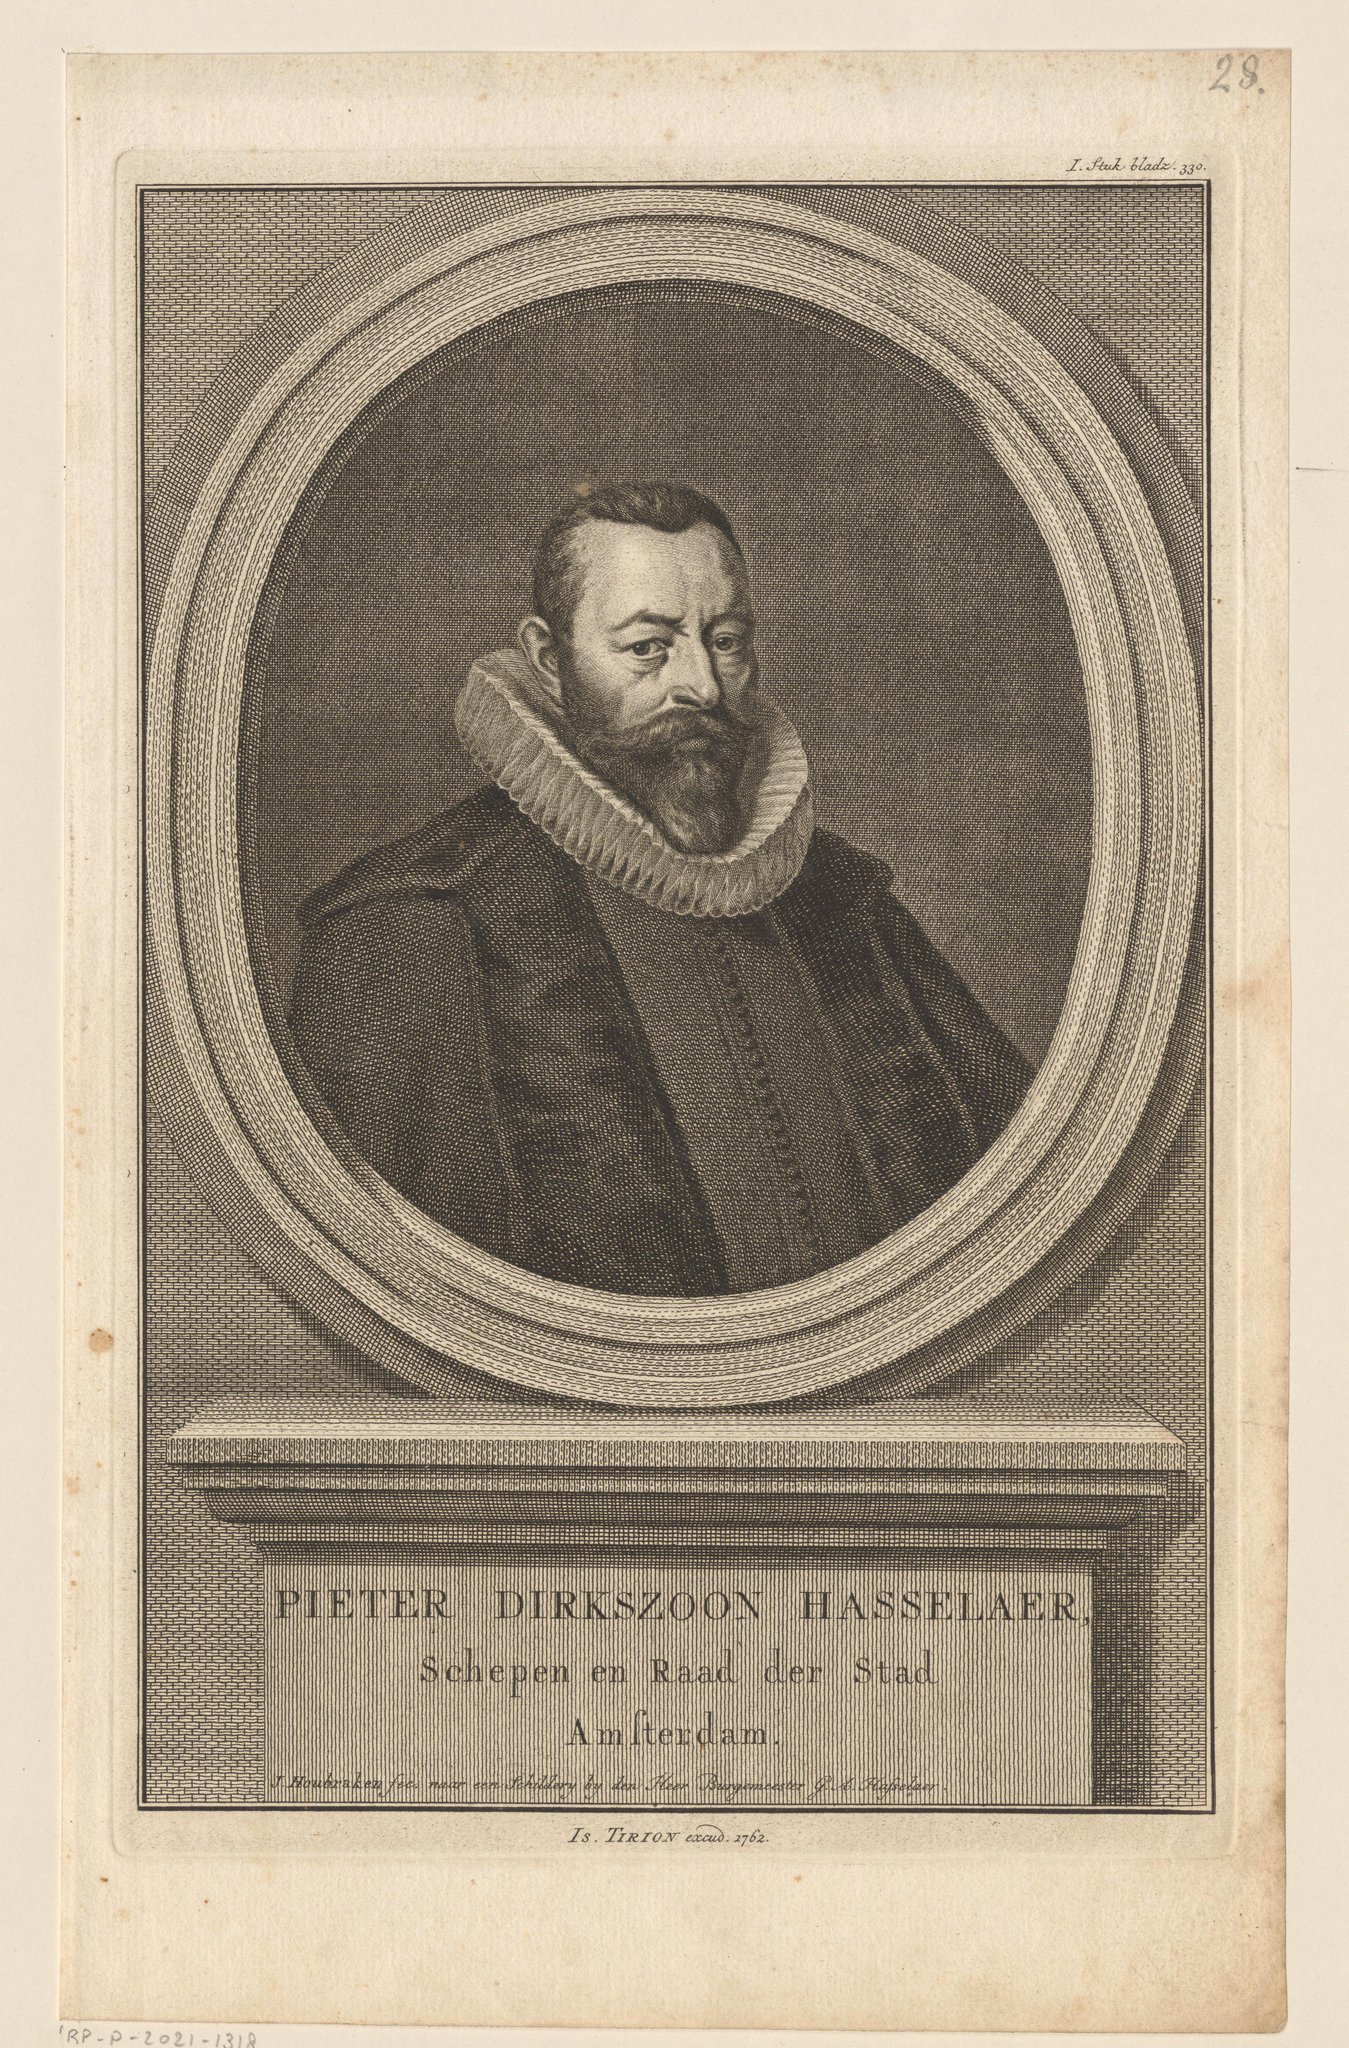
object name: print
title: Portret van Pieter Dirksz. Hasselaer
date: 1762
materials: paper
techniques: engraving, etching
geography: amsterdam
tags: amsterdam, historical persons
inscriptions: date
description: Rechtsboven genummerd: I. stuk bladz. 330.